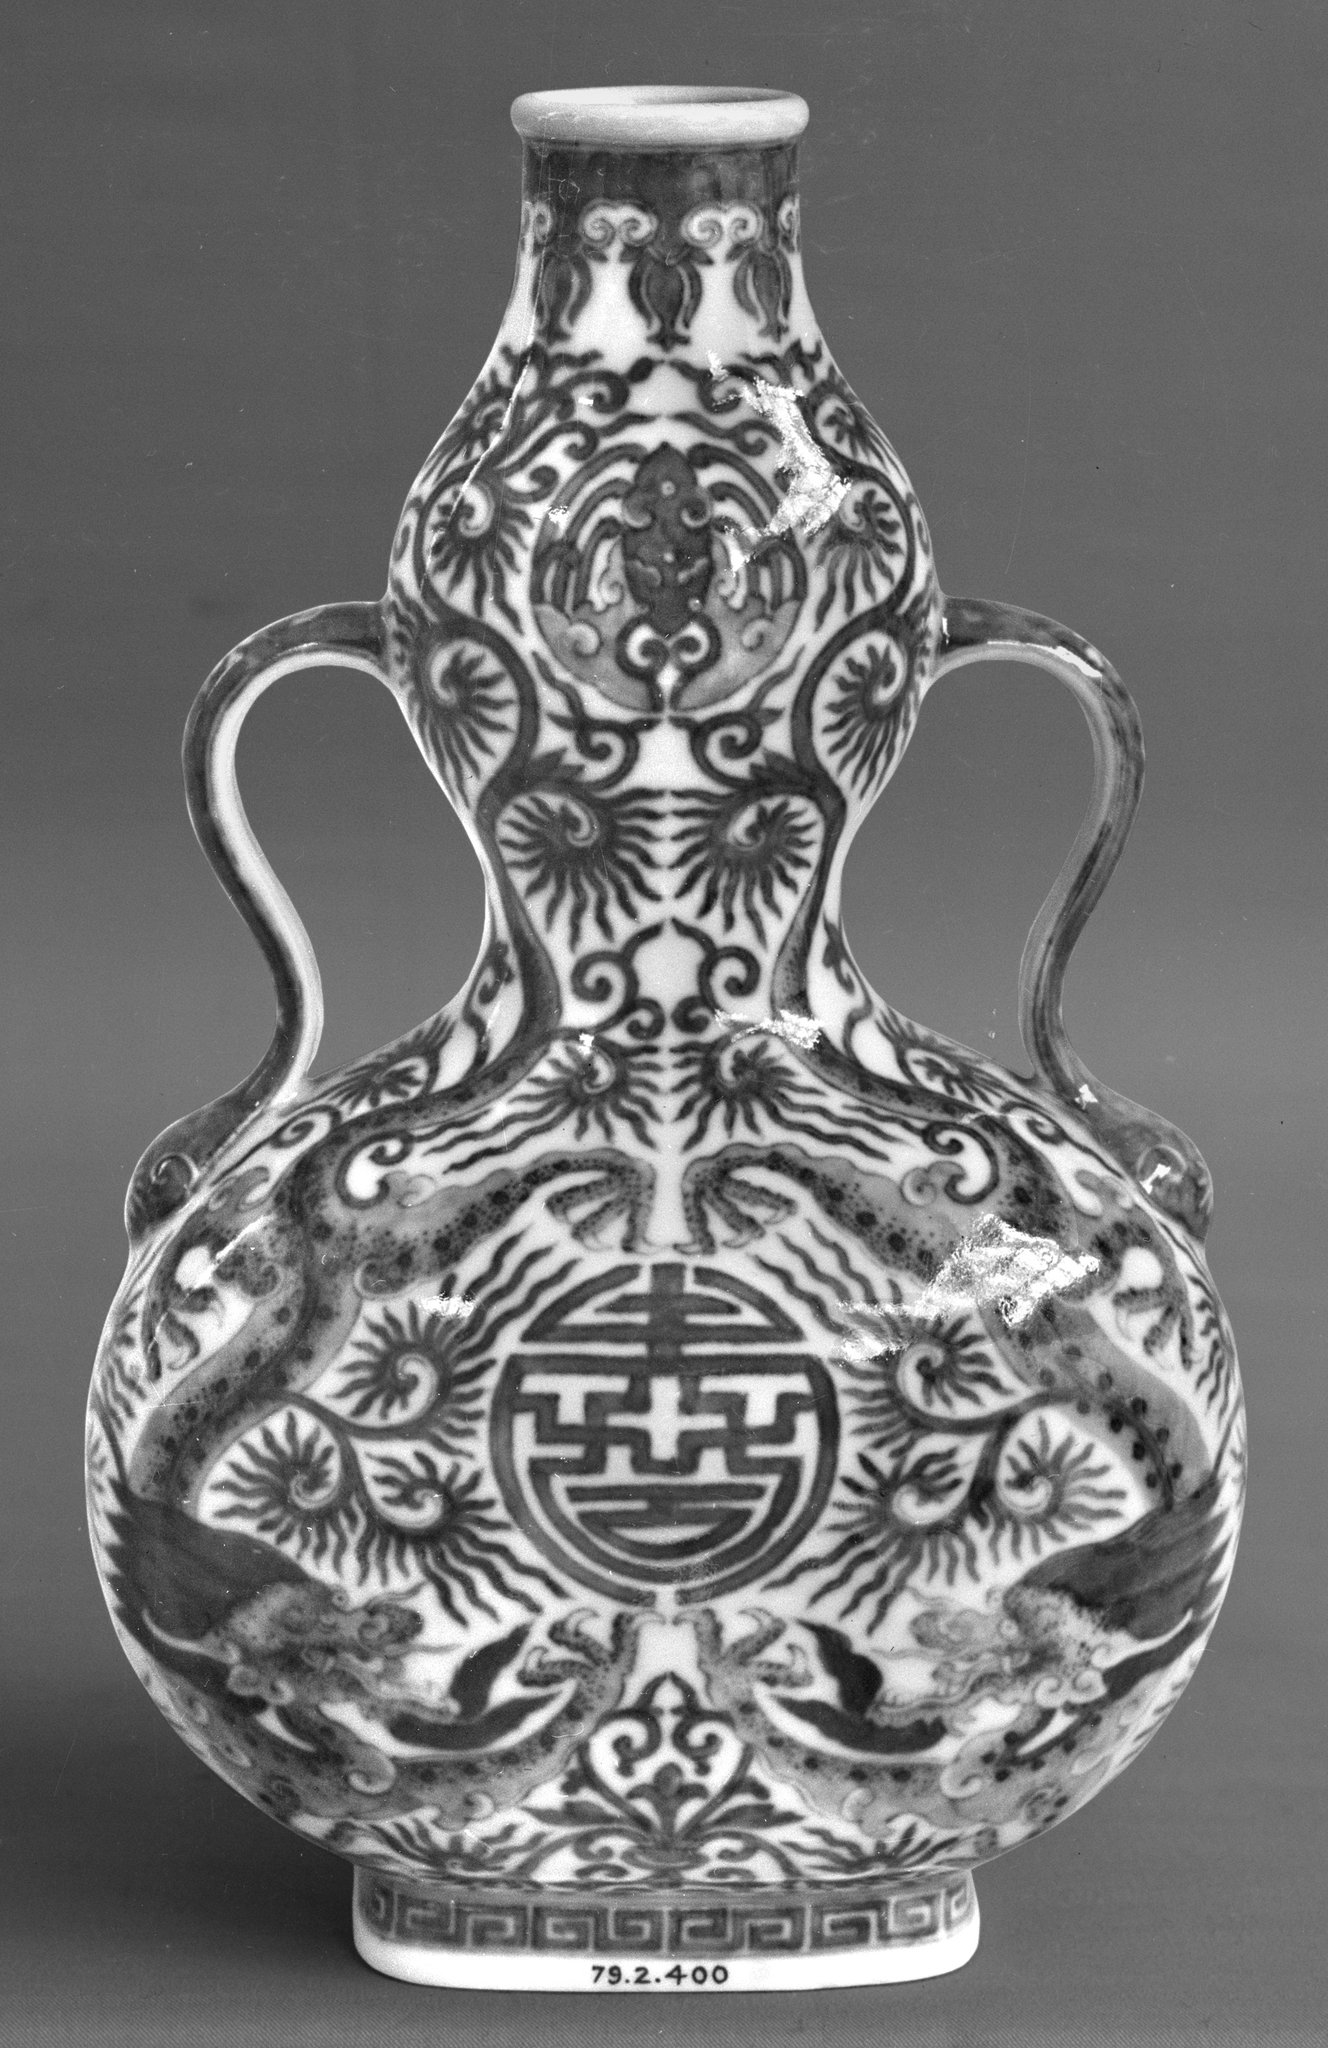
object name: bottle with handle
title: Double gourd bottle with handles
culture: chinese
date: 1801-1833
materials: cobalt, porcelain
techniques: painting, underglaze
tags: dragons